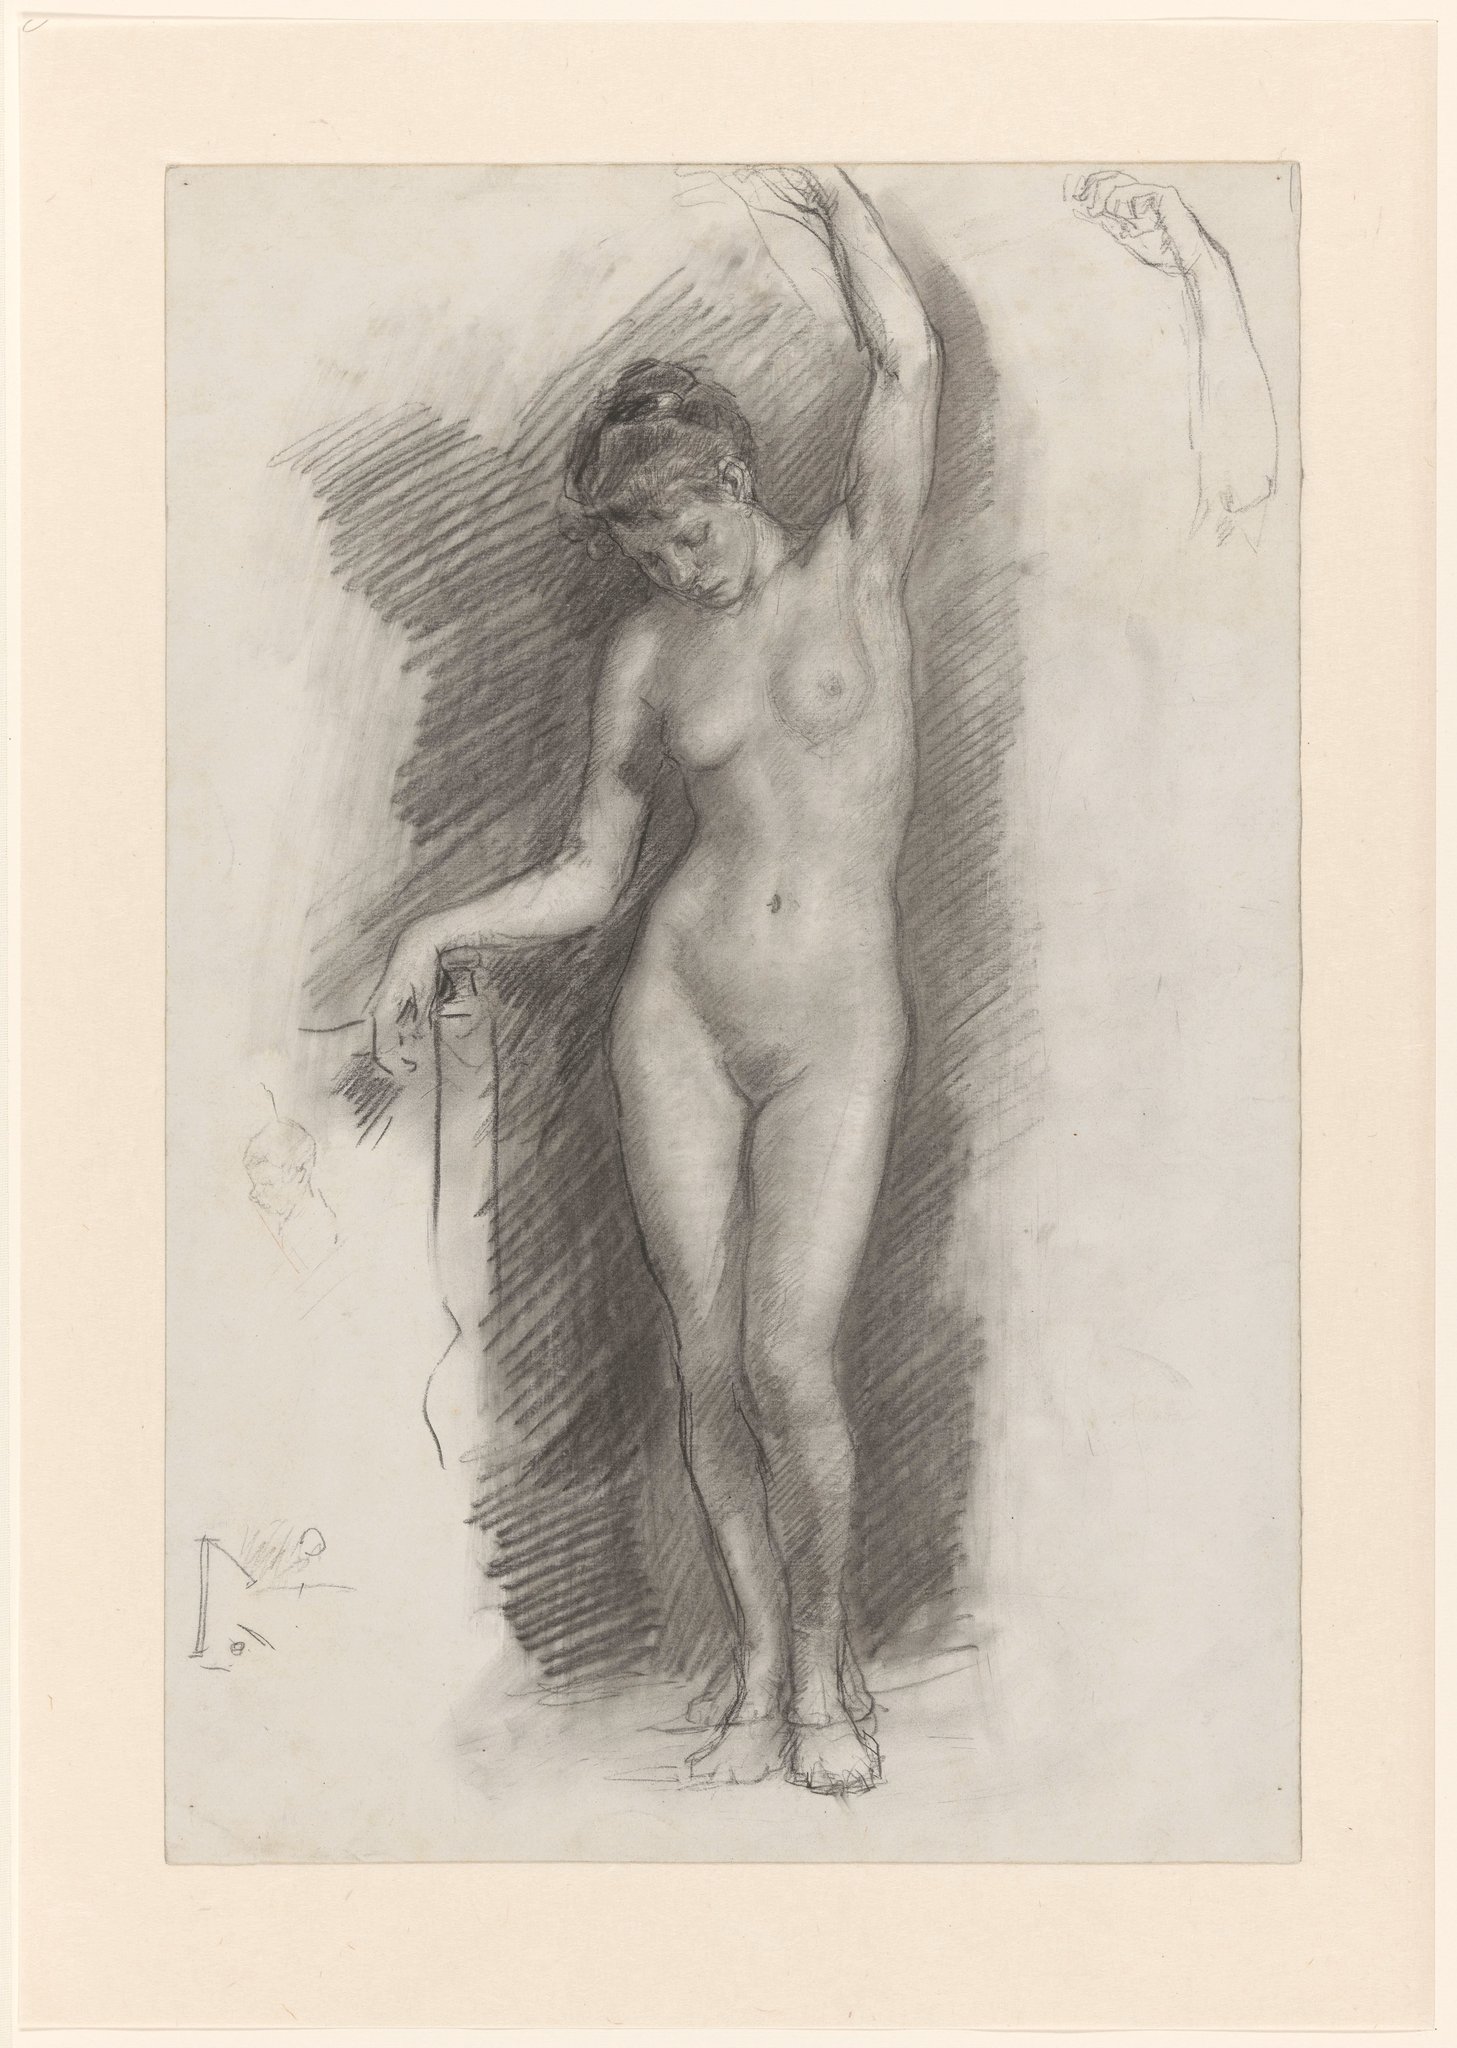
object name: drawing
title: Standing Female Nude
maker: johan antonie de jonge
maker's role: draughtsman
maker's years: 1864-1927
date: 1874-1927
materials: chalk, paper